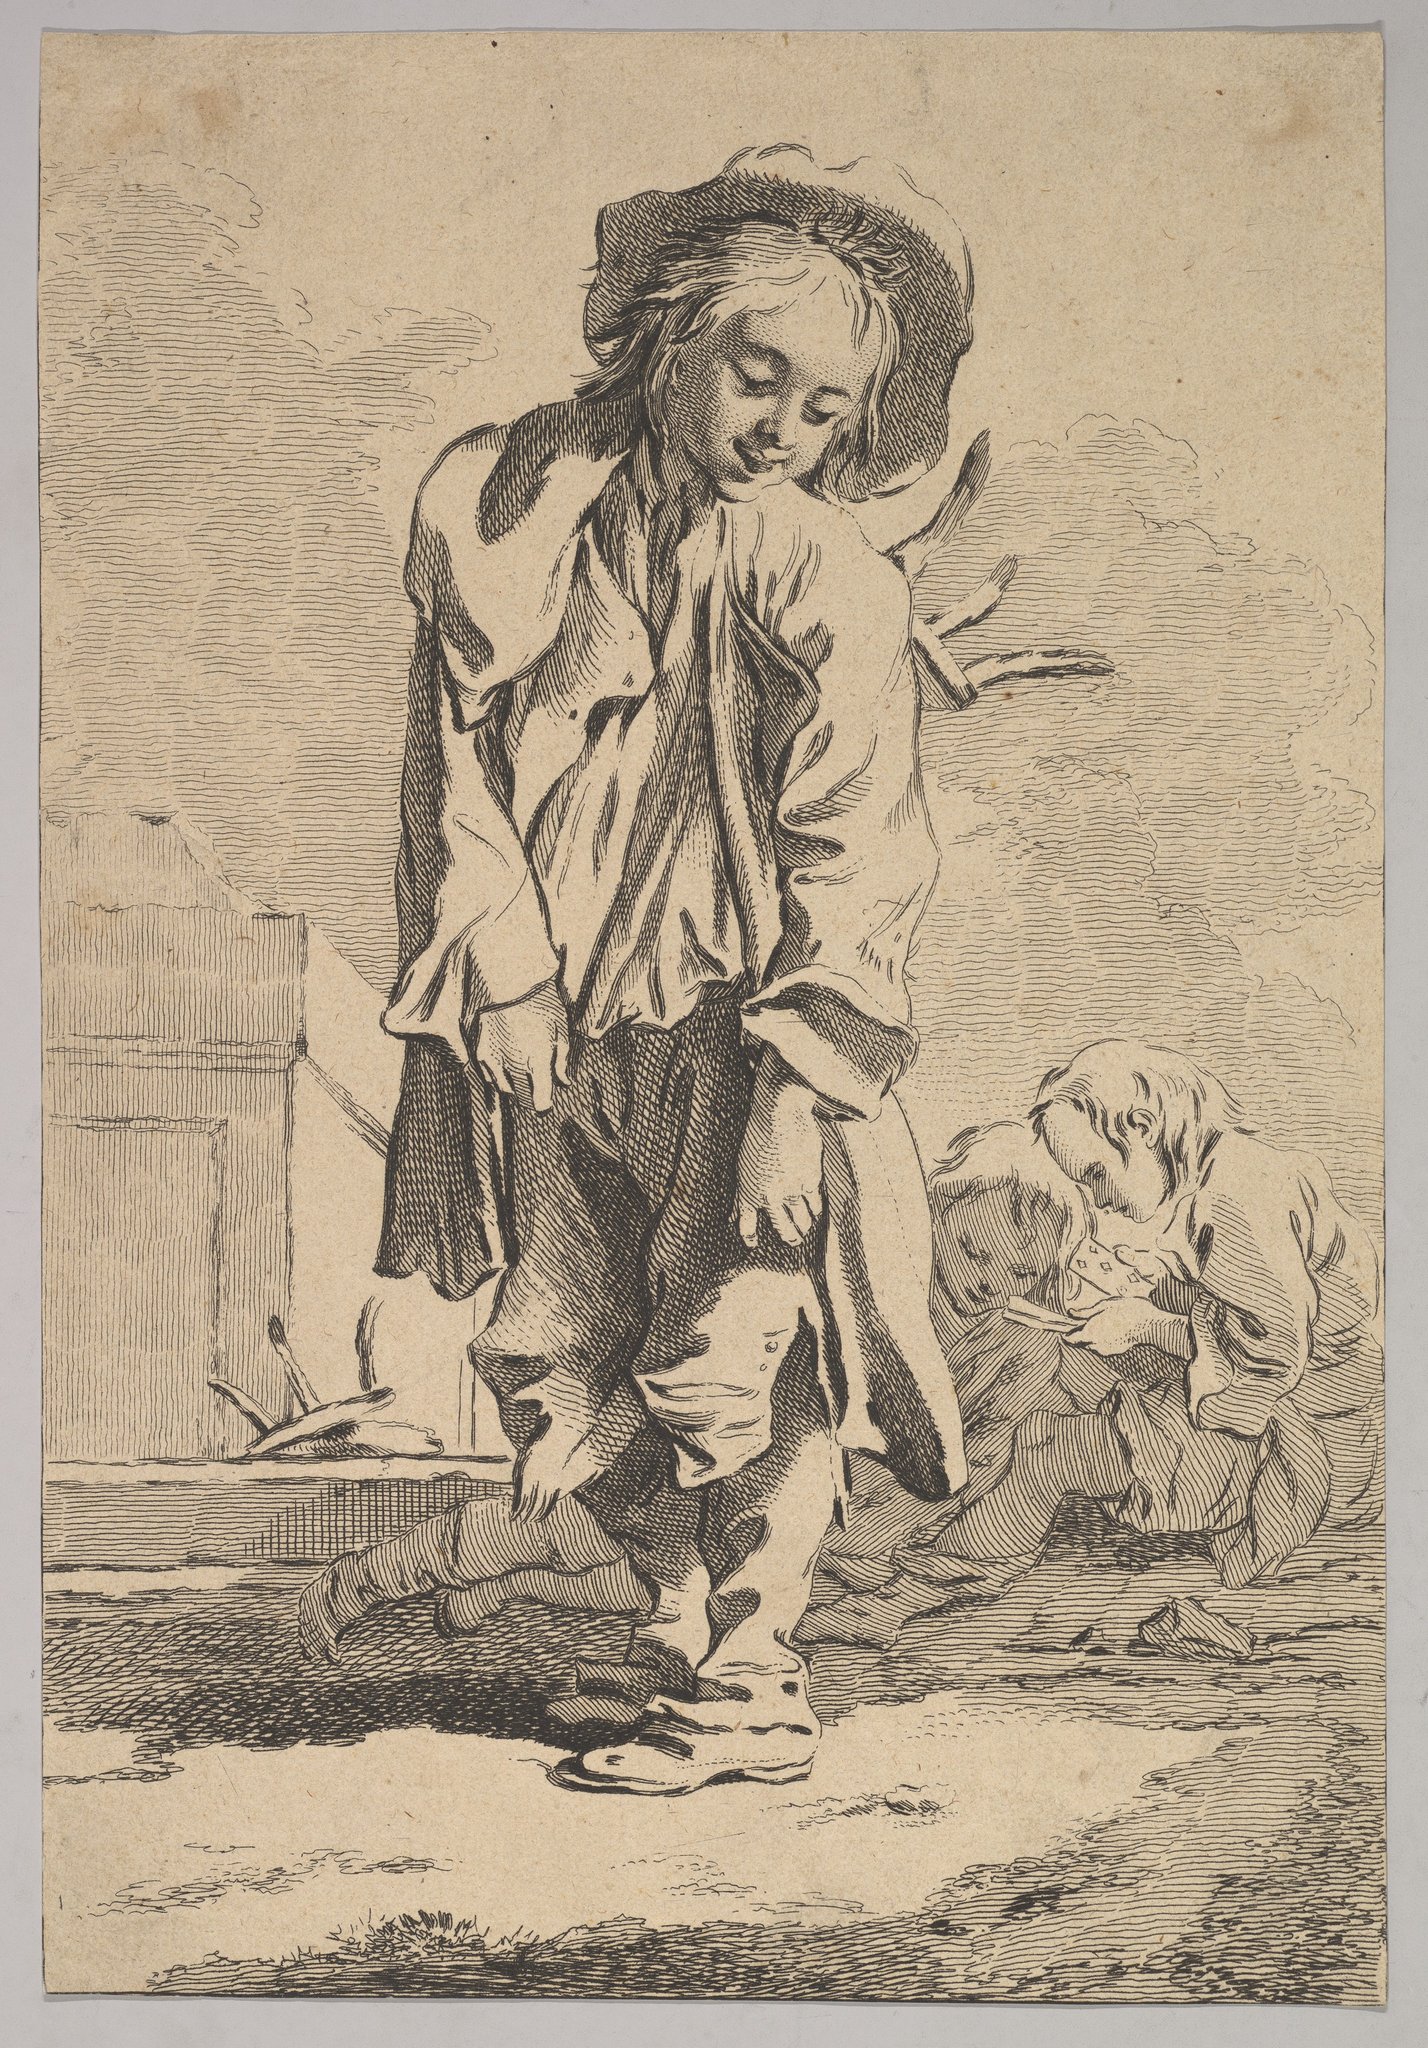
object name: print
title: Sweeping from Top to Bottom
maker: jacques philippe le bas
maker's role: artist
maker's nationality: french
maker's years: 1707-1783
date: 1707-1783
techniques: engraving, etching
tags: boys,playing cards